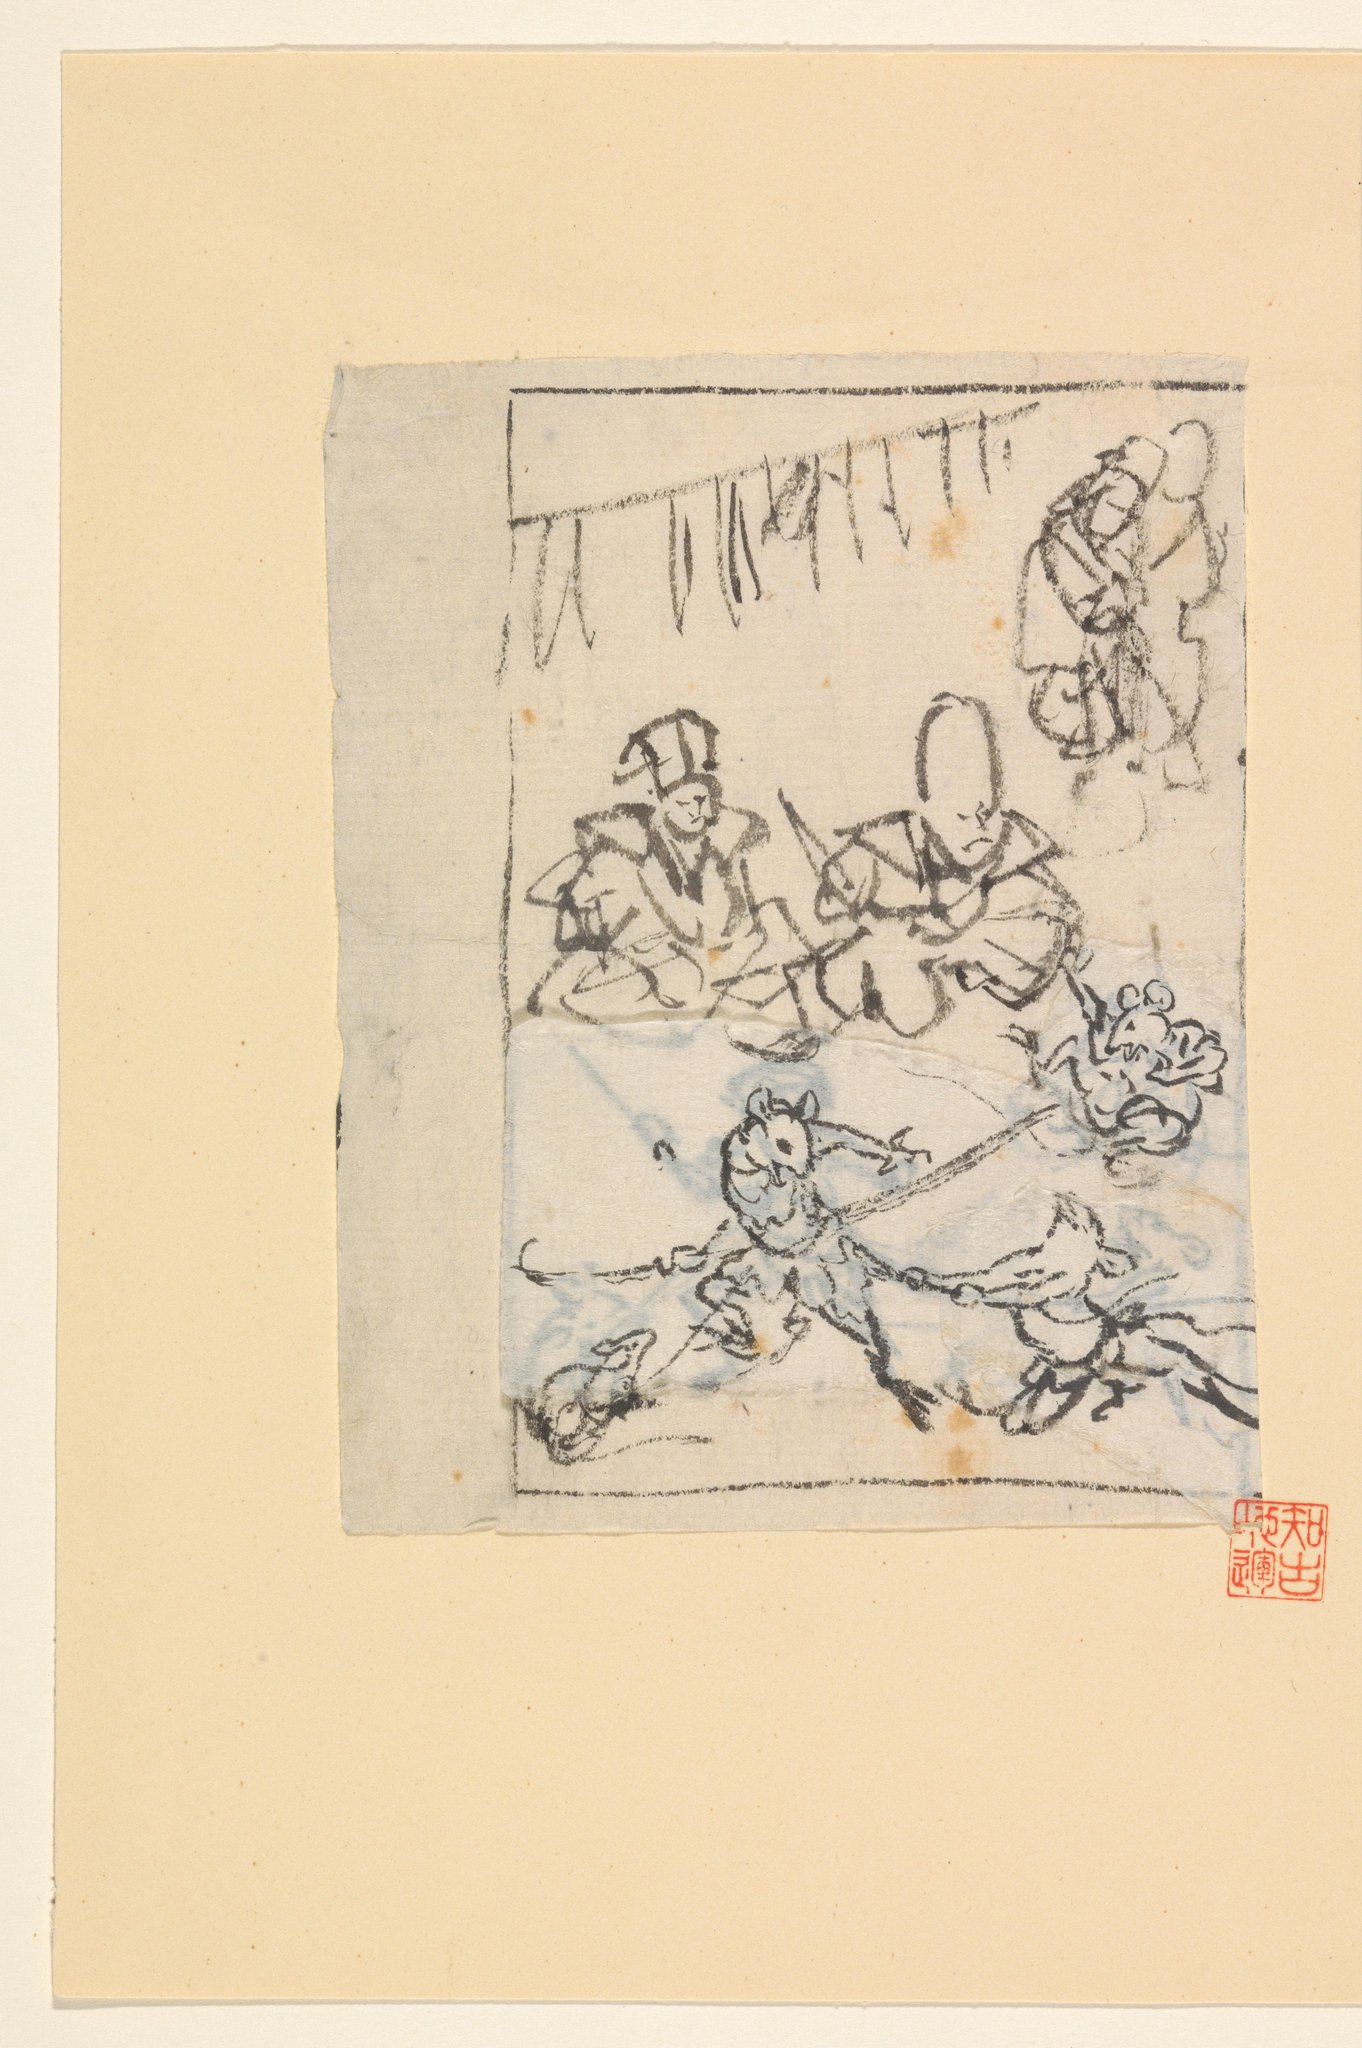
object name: drawing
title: Daikoku en Fukurokuju zien toe bij een muizengevecht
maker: Anonymous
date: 1700-1900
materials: paper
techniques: brush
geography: japan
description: Daikoku en Fukurokuji als toeschouwers bij een gevecht tussen muizen. Overgeplakte correctie.